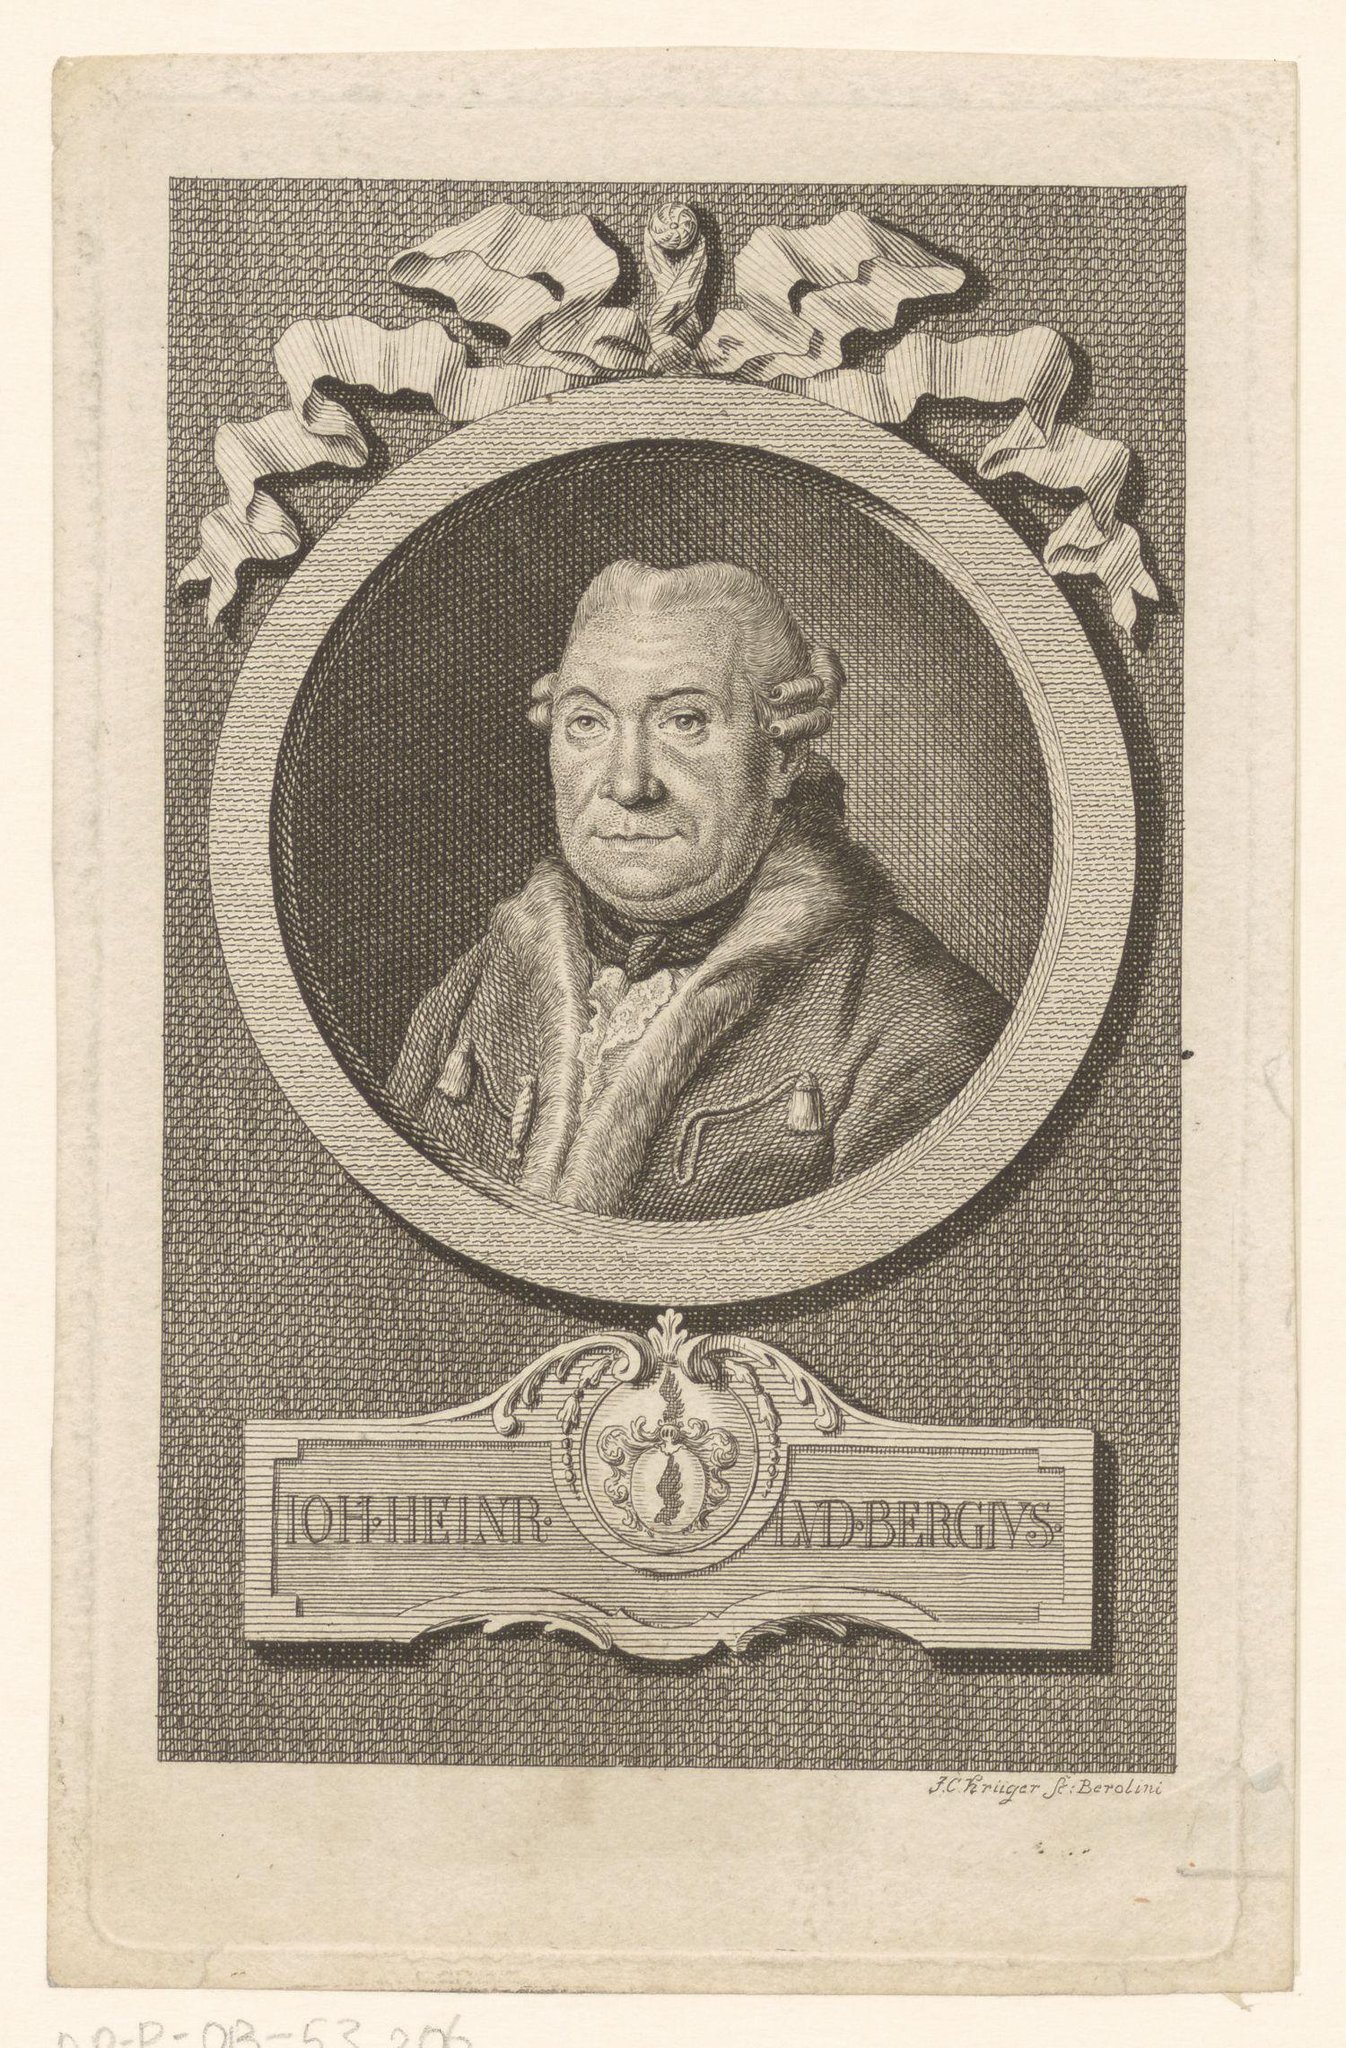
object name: print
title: Portret van Kohann Heinrich Ludwig Bergius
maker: johann conrad krüger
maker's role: artist, painter, print maker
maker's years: 1733-1791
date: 1743-1791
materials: paper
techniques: engraving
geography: berlin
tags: historical persons, counsellor